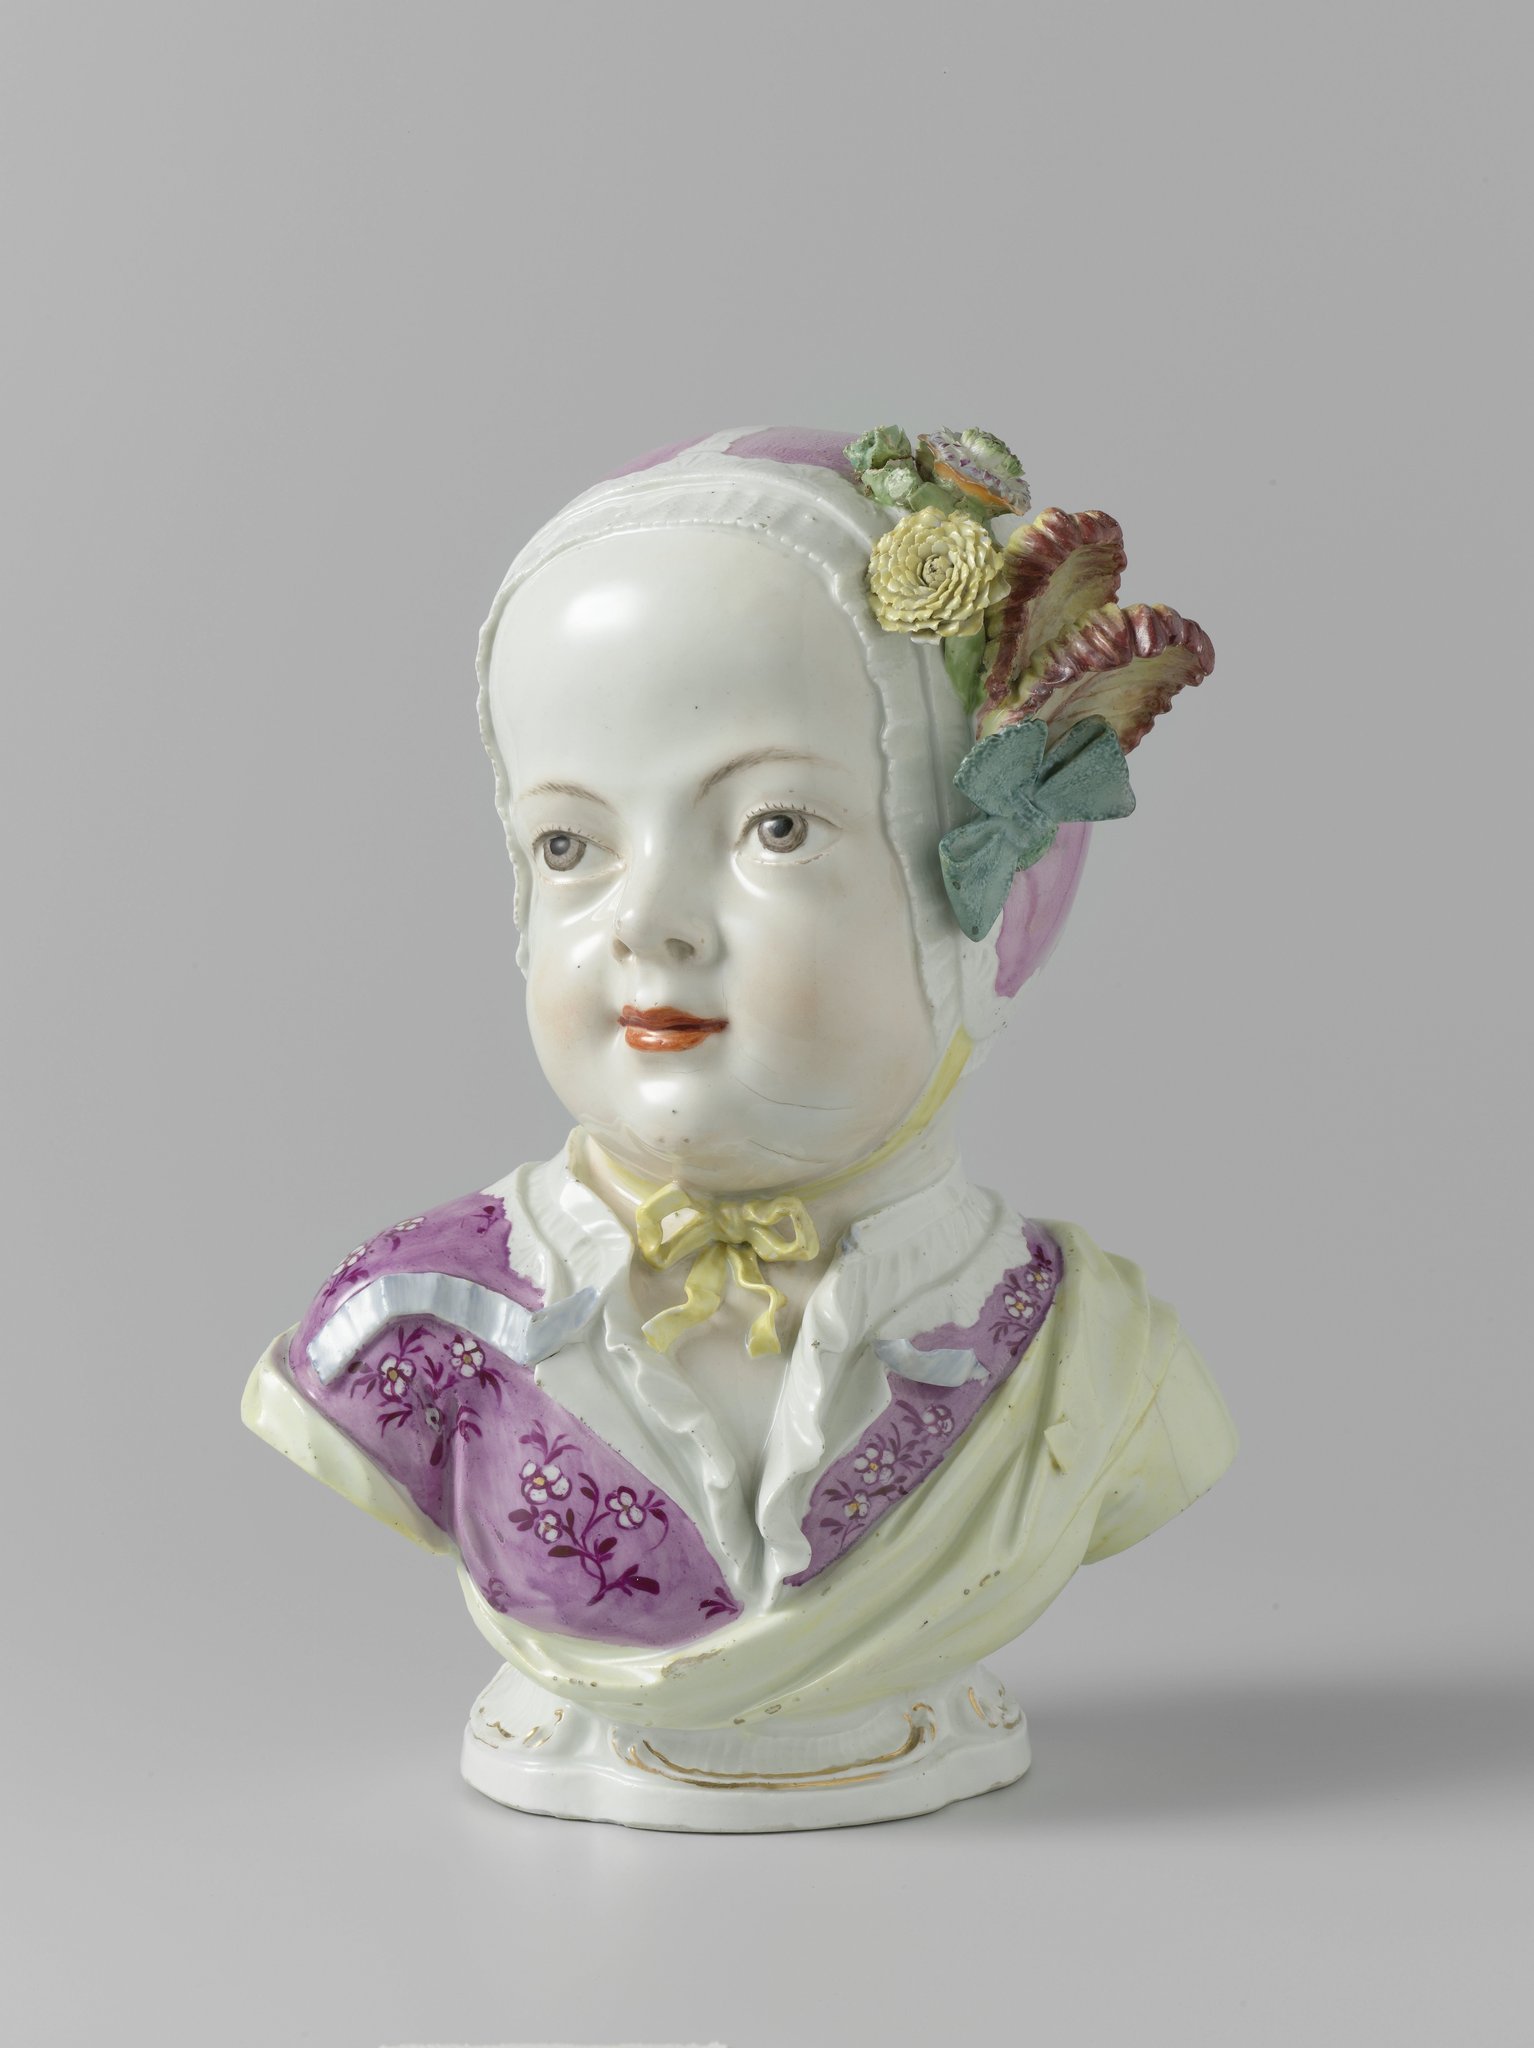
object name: figure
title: Two Busts of Children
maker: johann joachim kändler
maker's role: designer, sculptor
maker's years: 1706-1775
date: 1750-1760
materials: porcelain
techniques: painted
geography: meissen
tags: flowers, head-gear: cap (+ children's clothes), child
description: Meissener Porzellan Manufaktur, model attributed to Johann Joachim Kändler (1706–1775), Meissen, c. 1750–1760, hard-paste porcelain